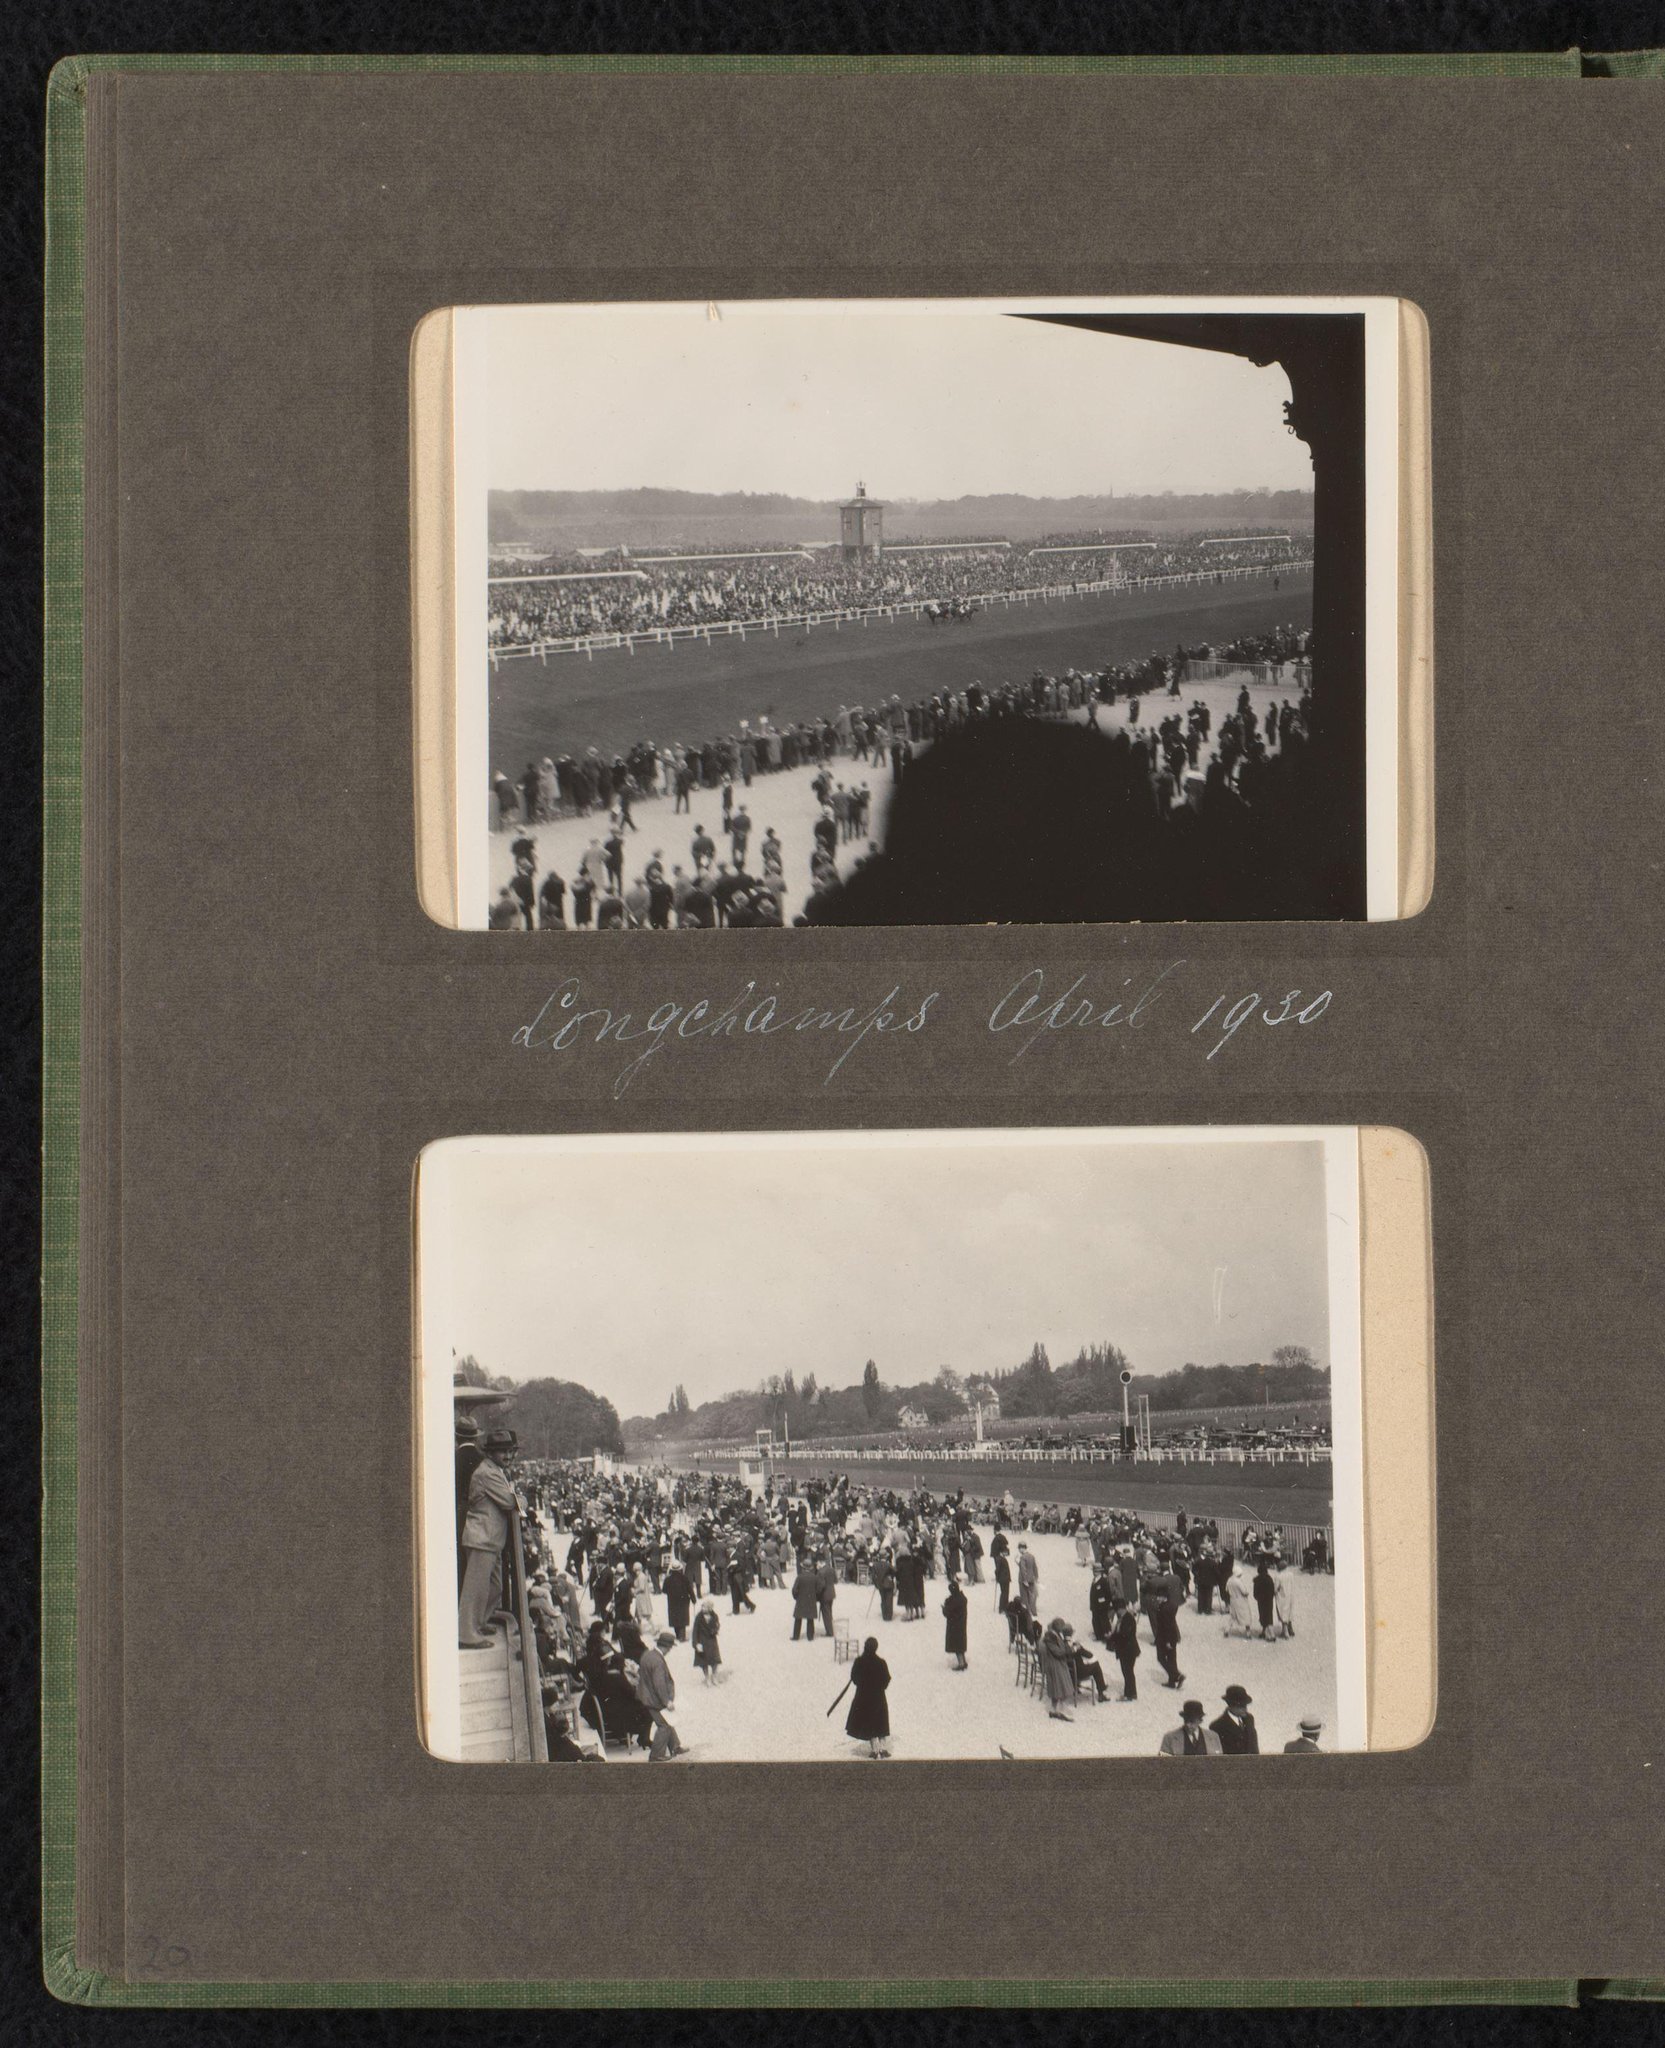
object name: album leaf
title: Twee foto's van het Hippodrome de Longchamp tijdens een paardenrace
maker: frank willem van den berg (1912-1998)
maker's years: 1912-1998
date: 1904-1930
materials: paper, cardboard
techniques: gelatin silver print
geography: paris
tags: race-track (+ out of doors (sports, games, etc.))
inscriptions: caption: ‘Longchamps April 1930’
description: Deze foto's maken deel uit van een album.